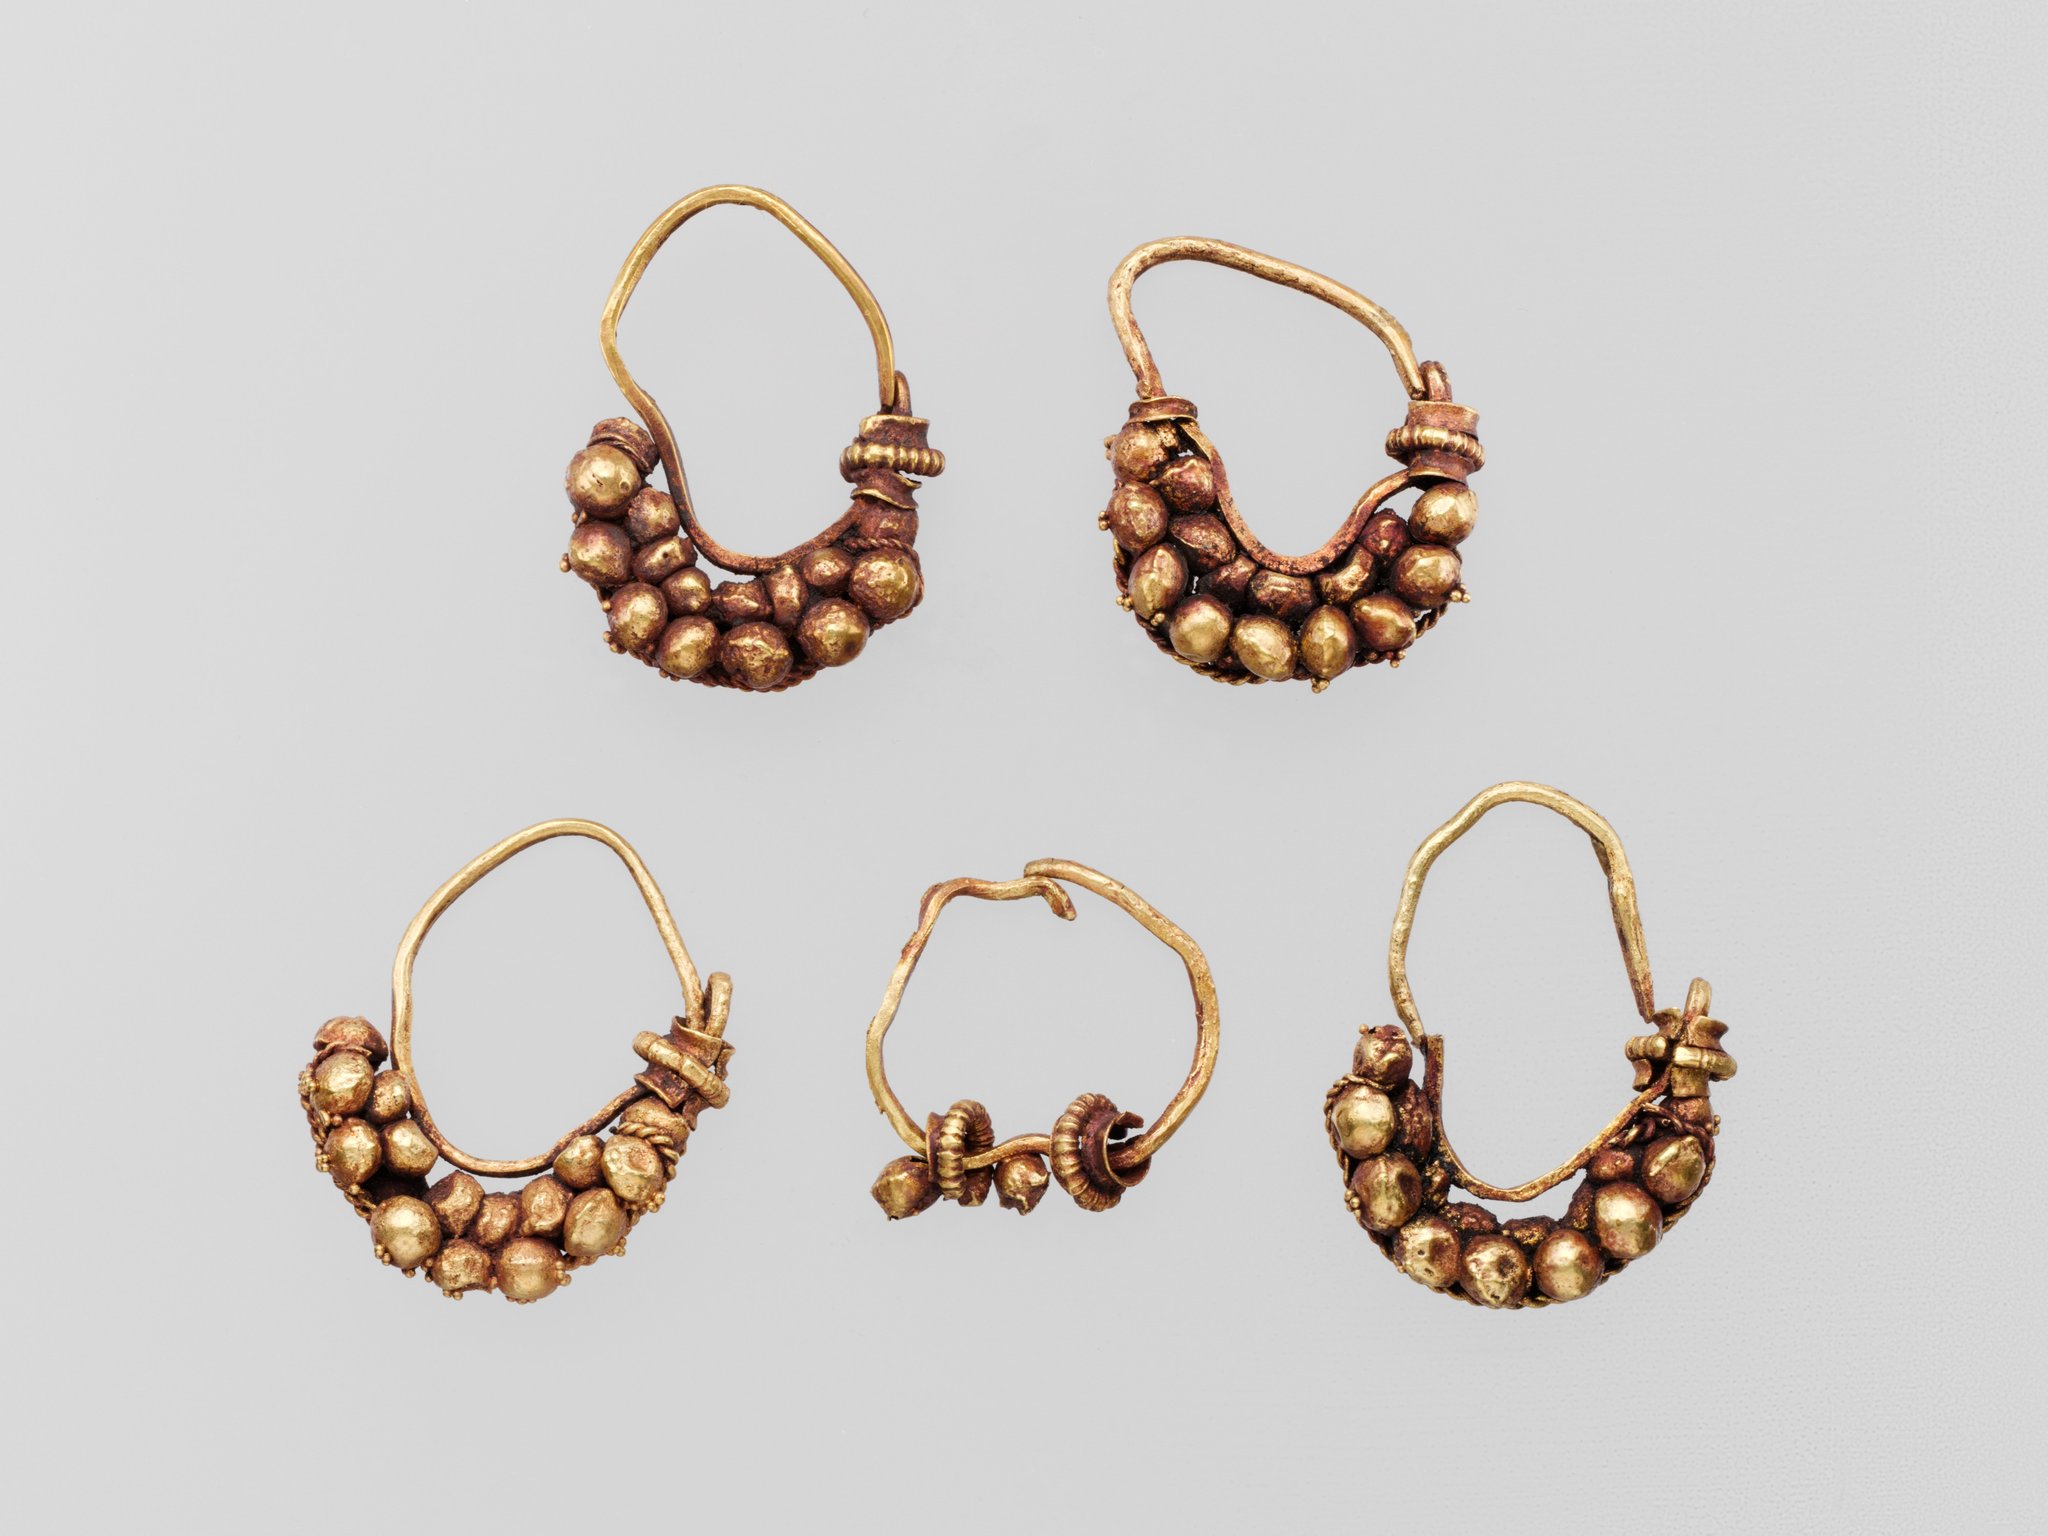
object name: earring, 5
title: Five gold earrings with spherical elements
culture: roman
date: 100 BCE-100 CE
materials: gold